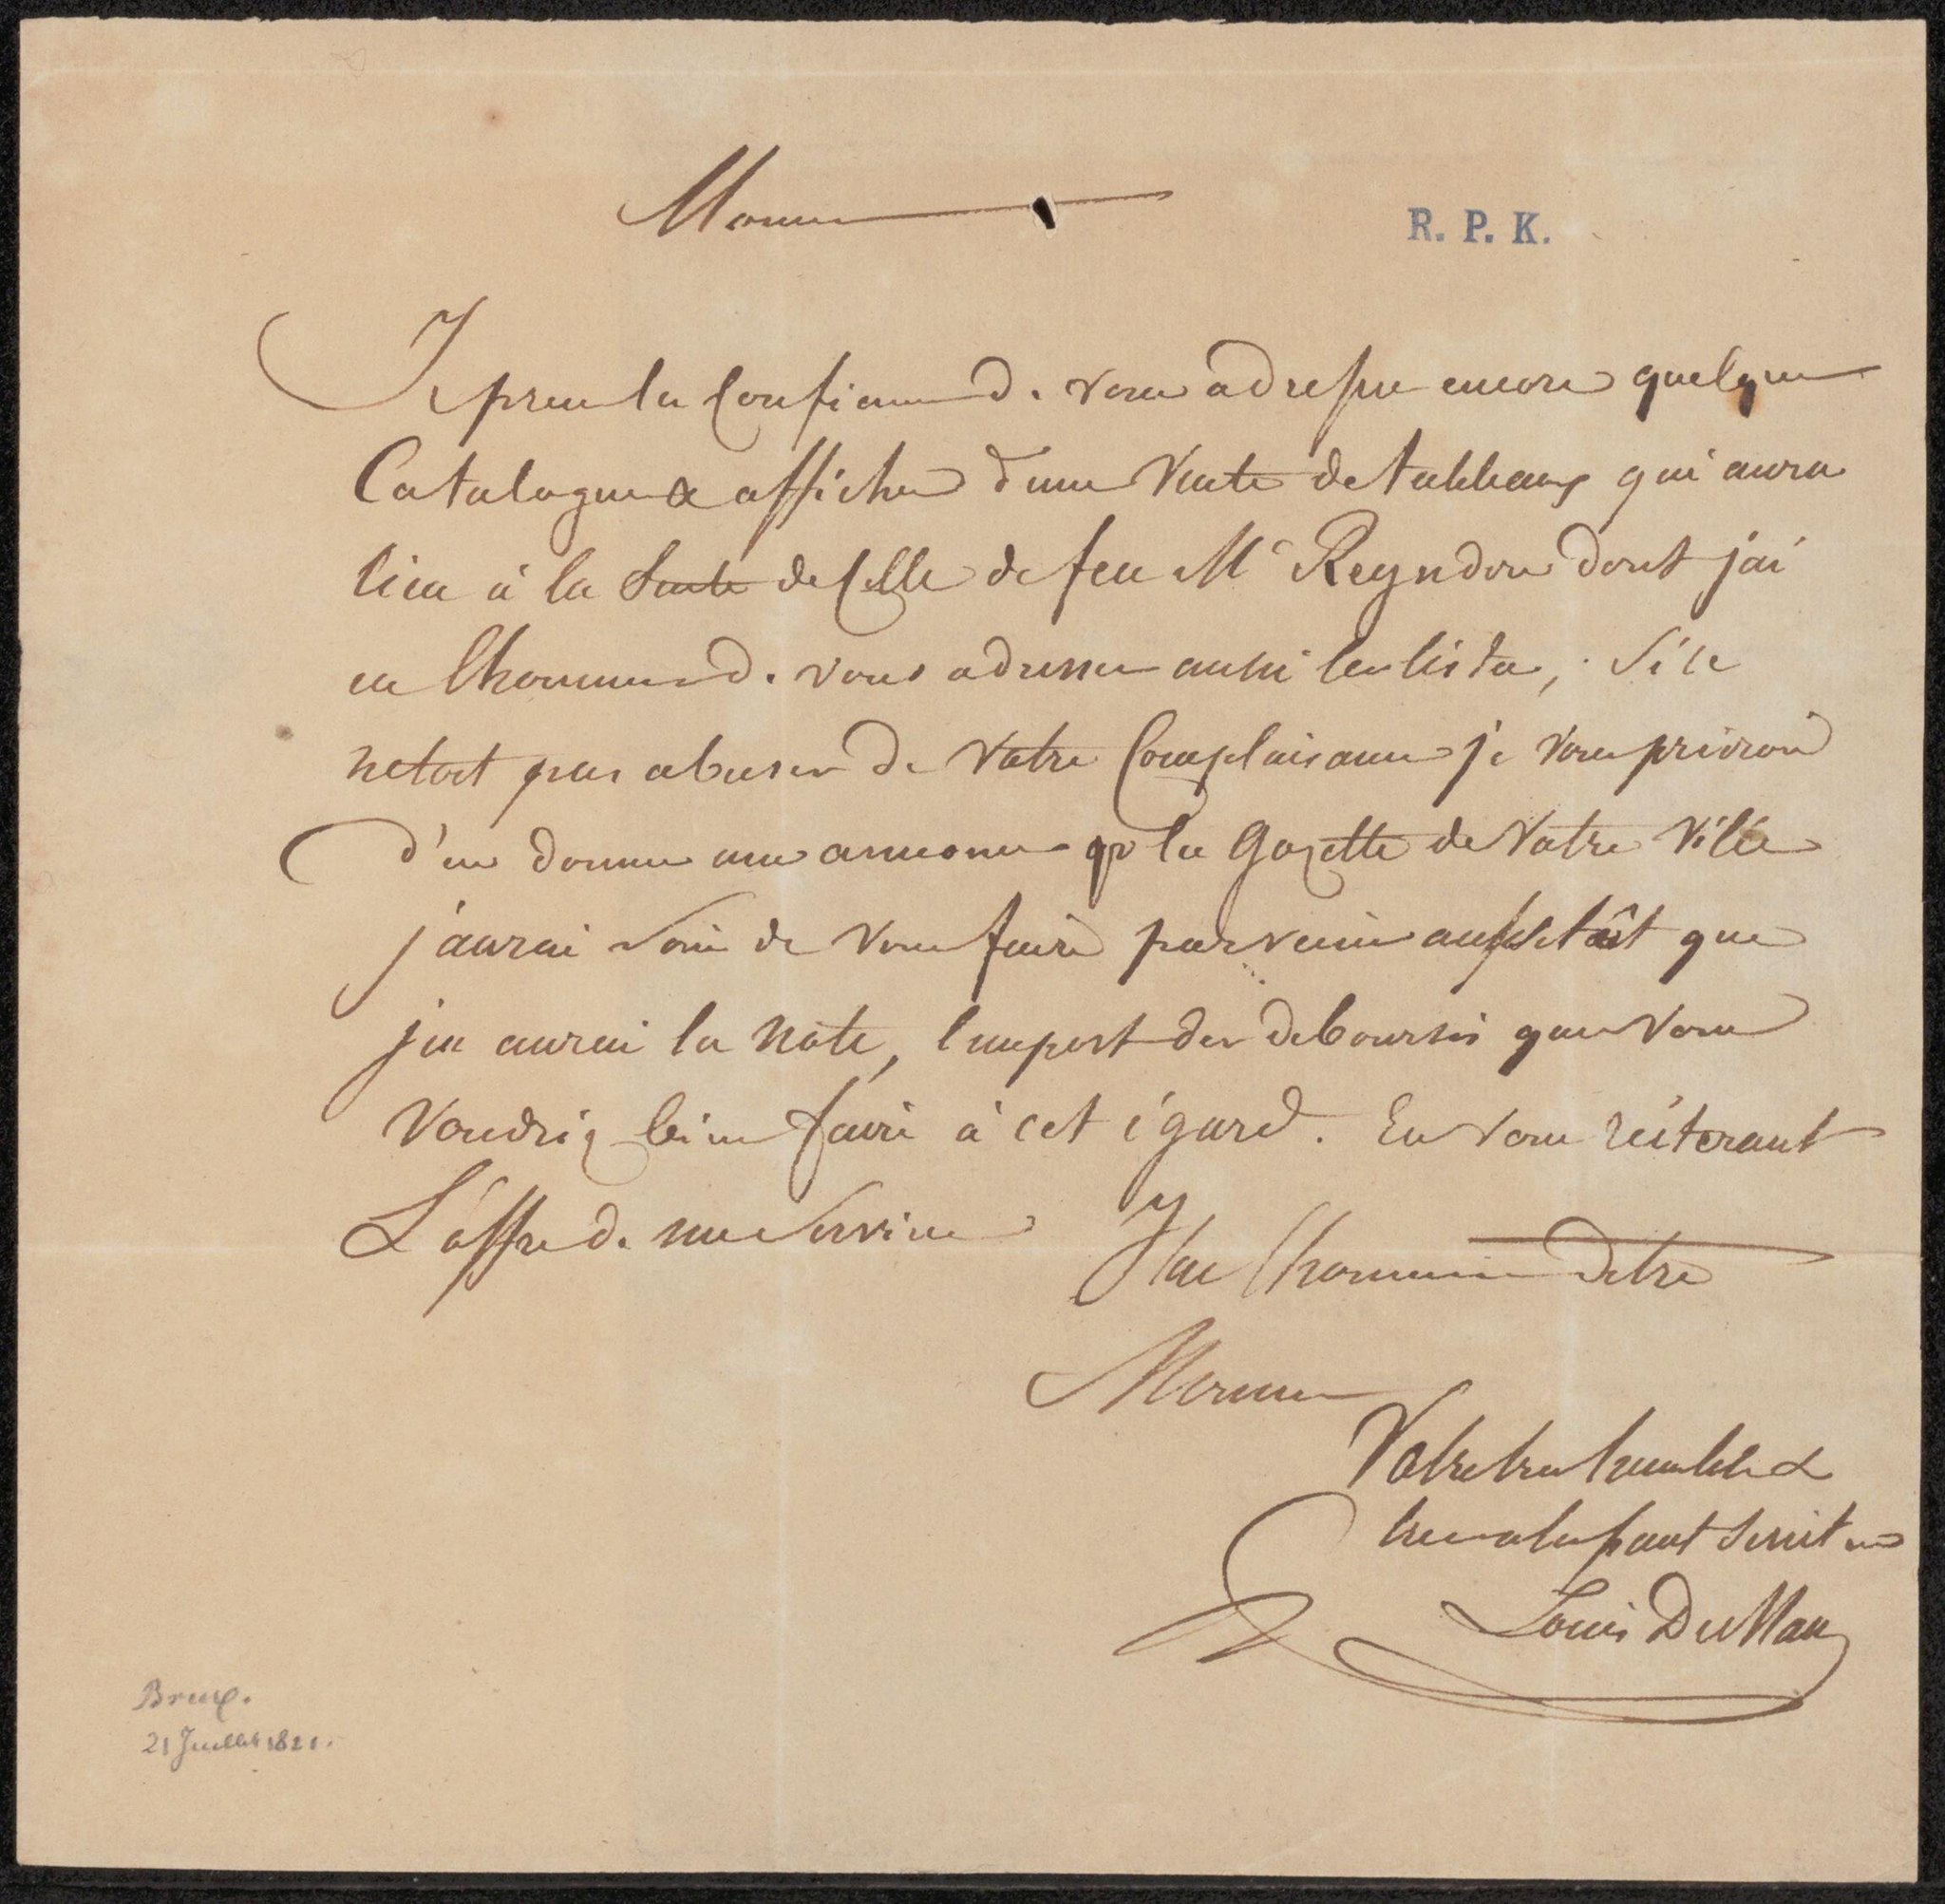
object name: letter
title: Brief aan anoniem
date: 1821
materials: ink, paper, pencil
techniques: pen, writing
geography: brussels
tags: utrecht, draughtsman, christiaan kramm, art trade, art shop, painting (including book-illumination, miniature-painting), printed matter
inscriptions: collector's mark: Lugt 2233